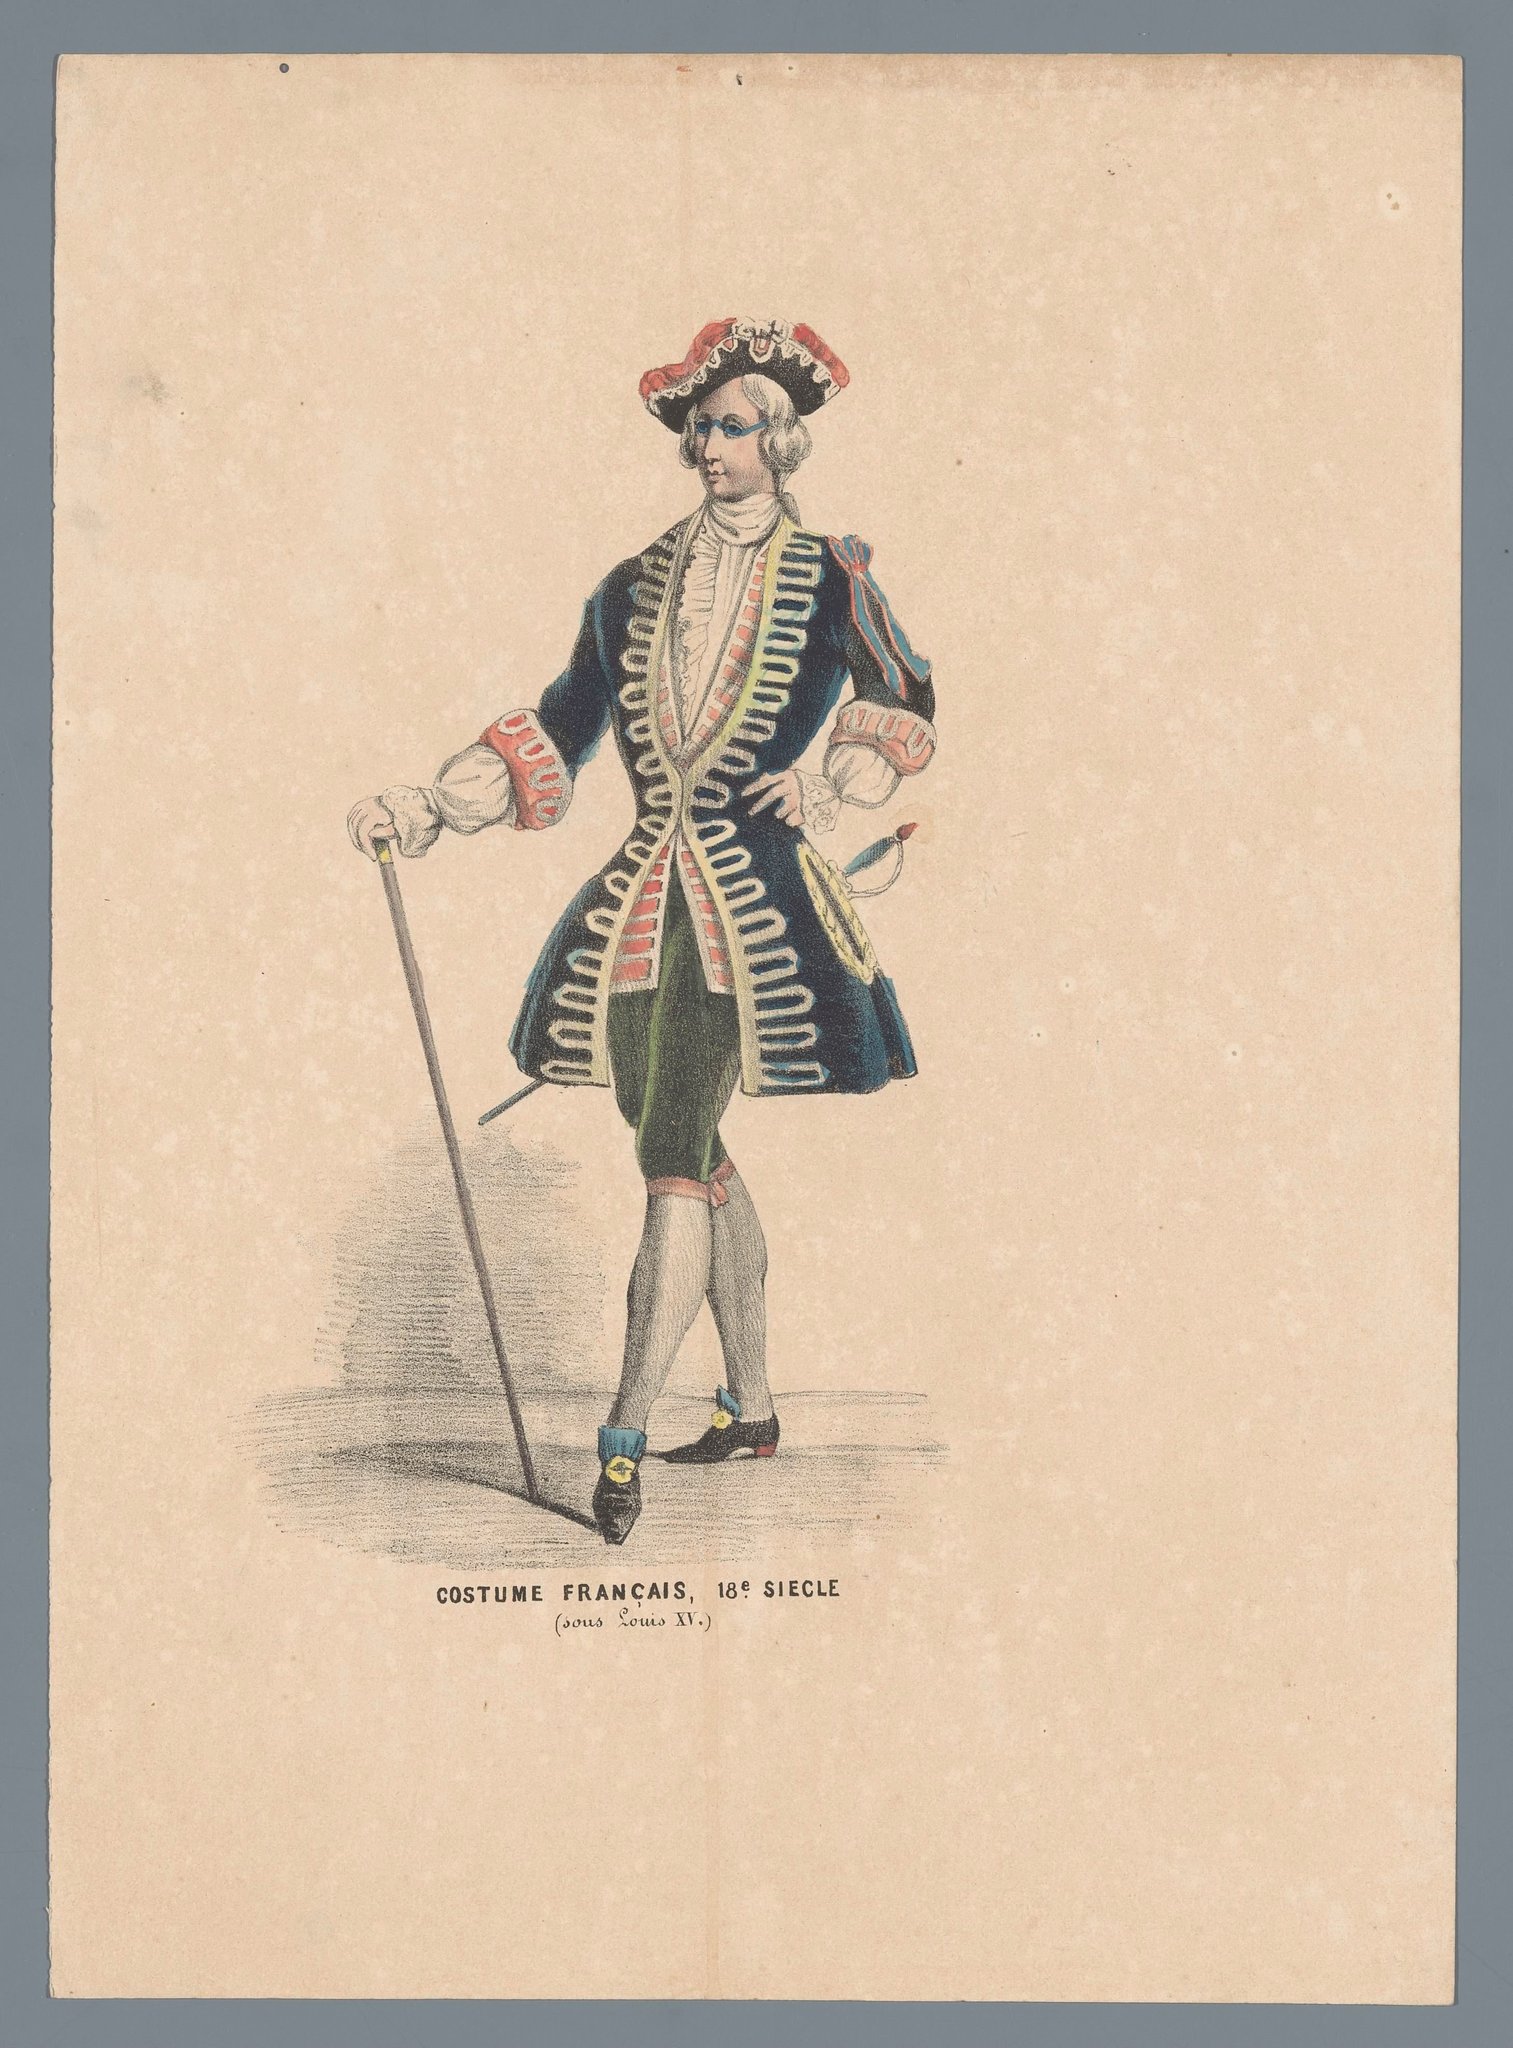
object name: costume print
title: Costume Français, 18e Siècle (sous Louis XV.)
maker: elias spanier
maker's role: print maker, printer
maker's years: 1821-1863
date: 1840-1850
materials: paper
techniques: hand coloring, lithograph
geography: the hague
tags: historical costume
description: Man in Frans historisch kostuum ten tijde van Lodewijk XV, 18e eeuw. Voorstelling toegevoegd aan het plaatwerk over het gekostumeerd bal gehouden op het paleis van de prins van Oranje (de latere koning Willem III) in Den Haag op 26 februari 1845.